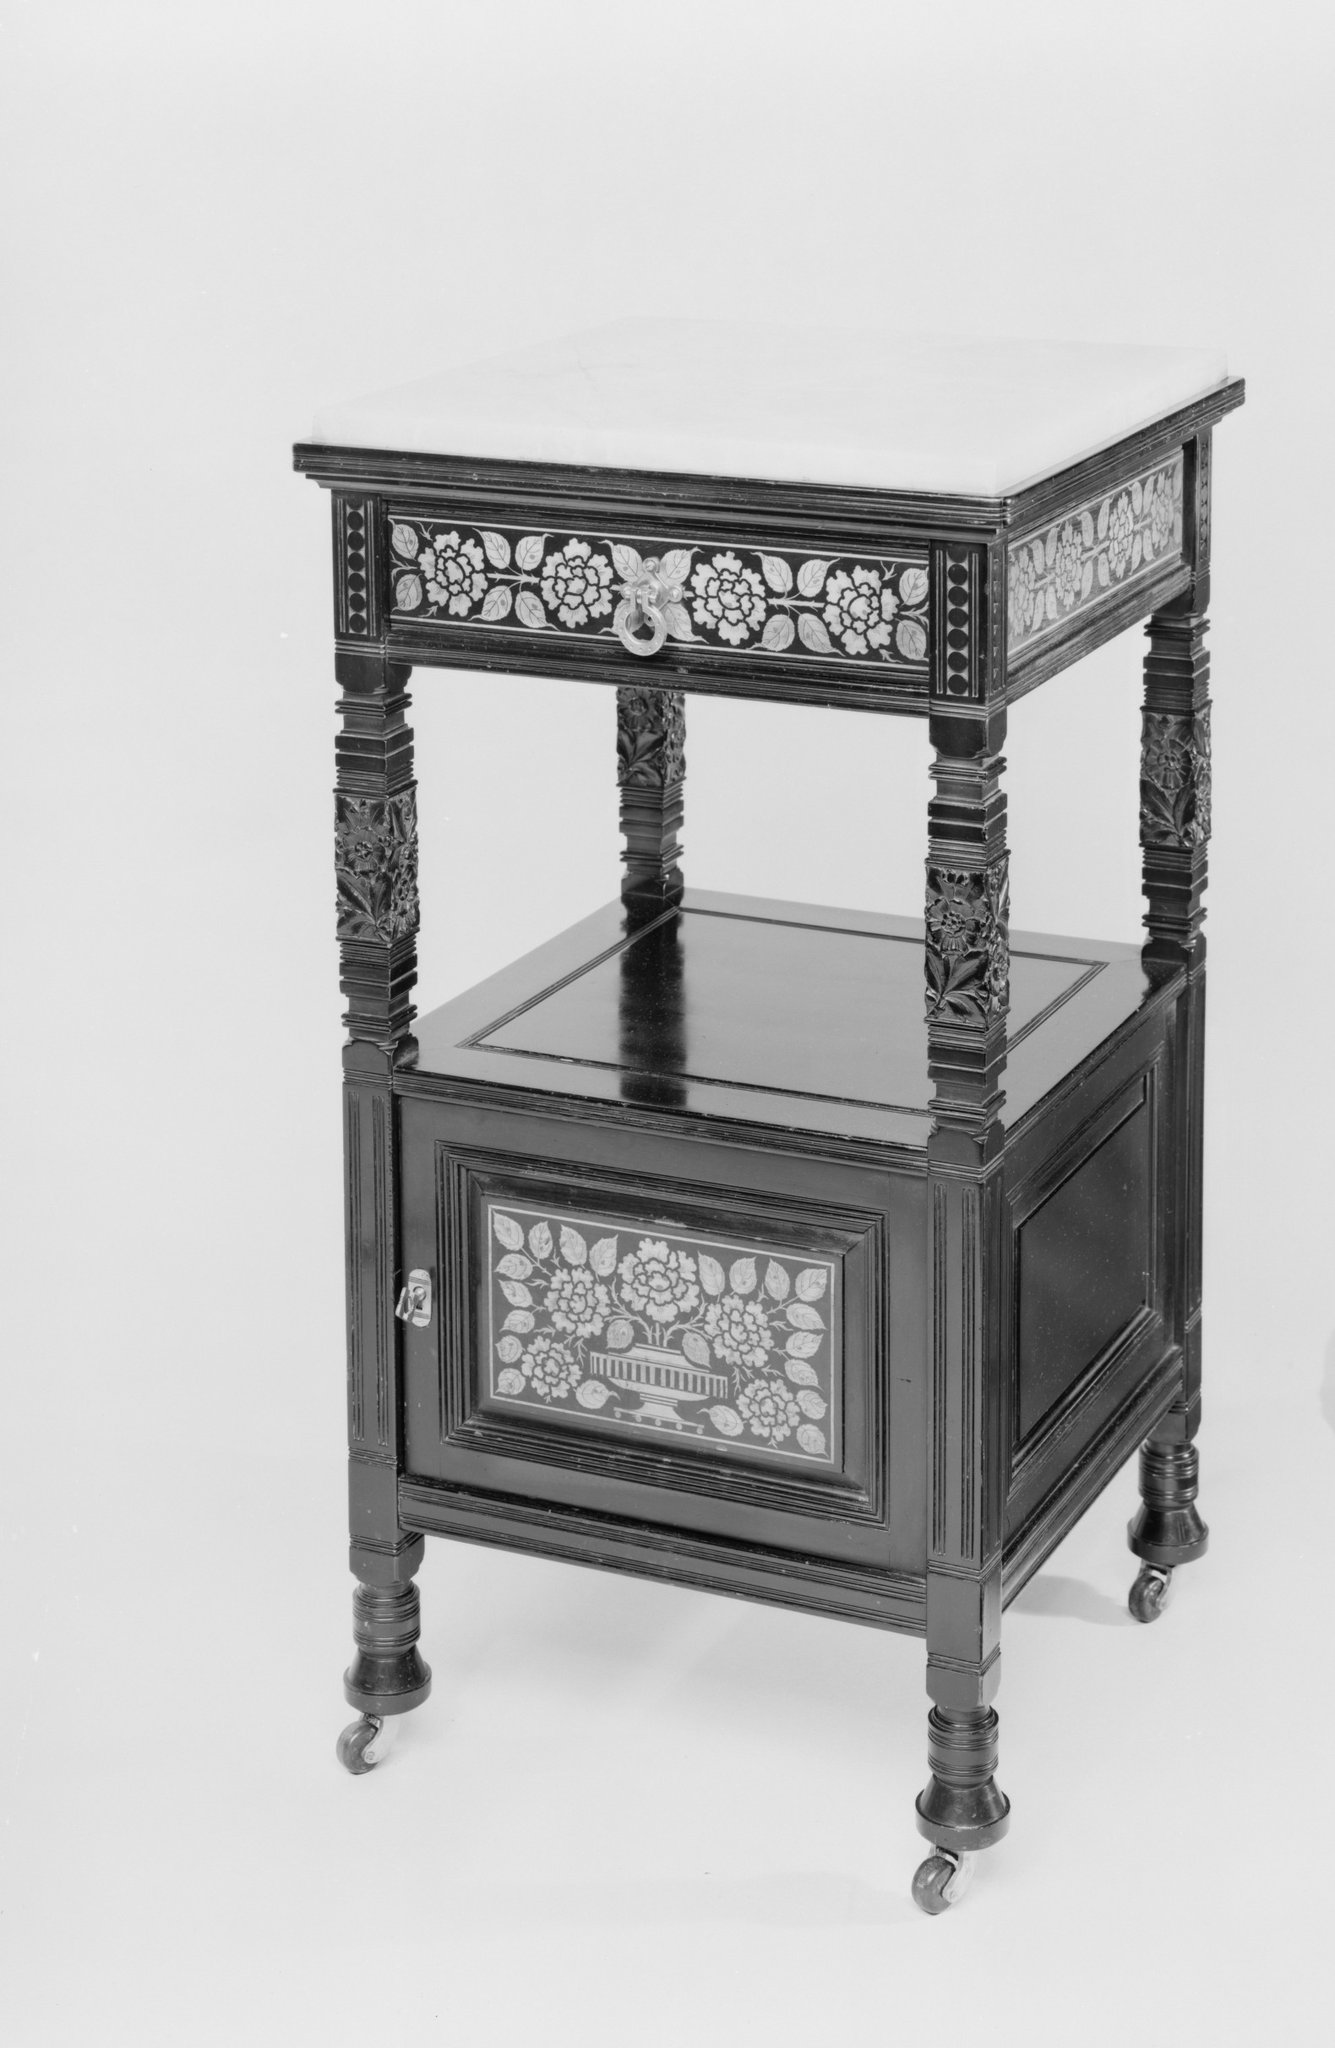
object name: night table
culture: american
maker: herter brothers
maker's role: maker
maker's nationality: american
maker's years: 1864-1906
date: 1880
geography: united states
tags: flowers